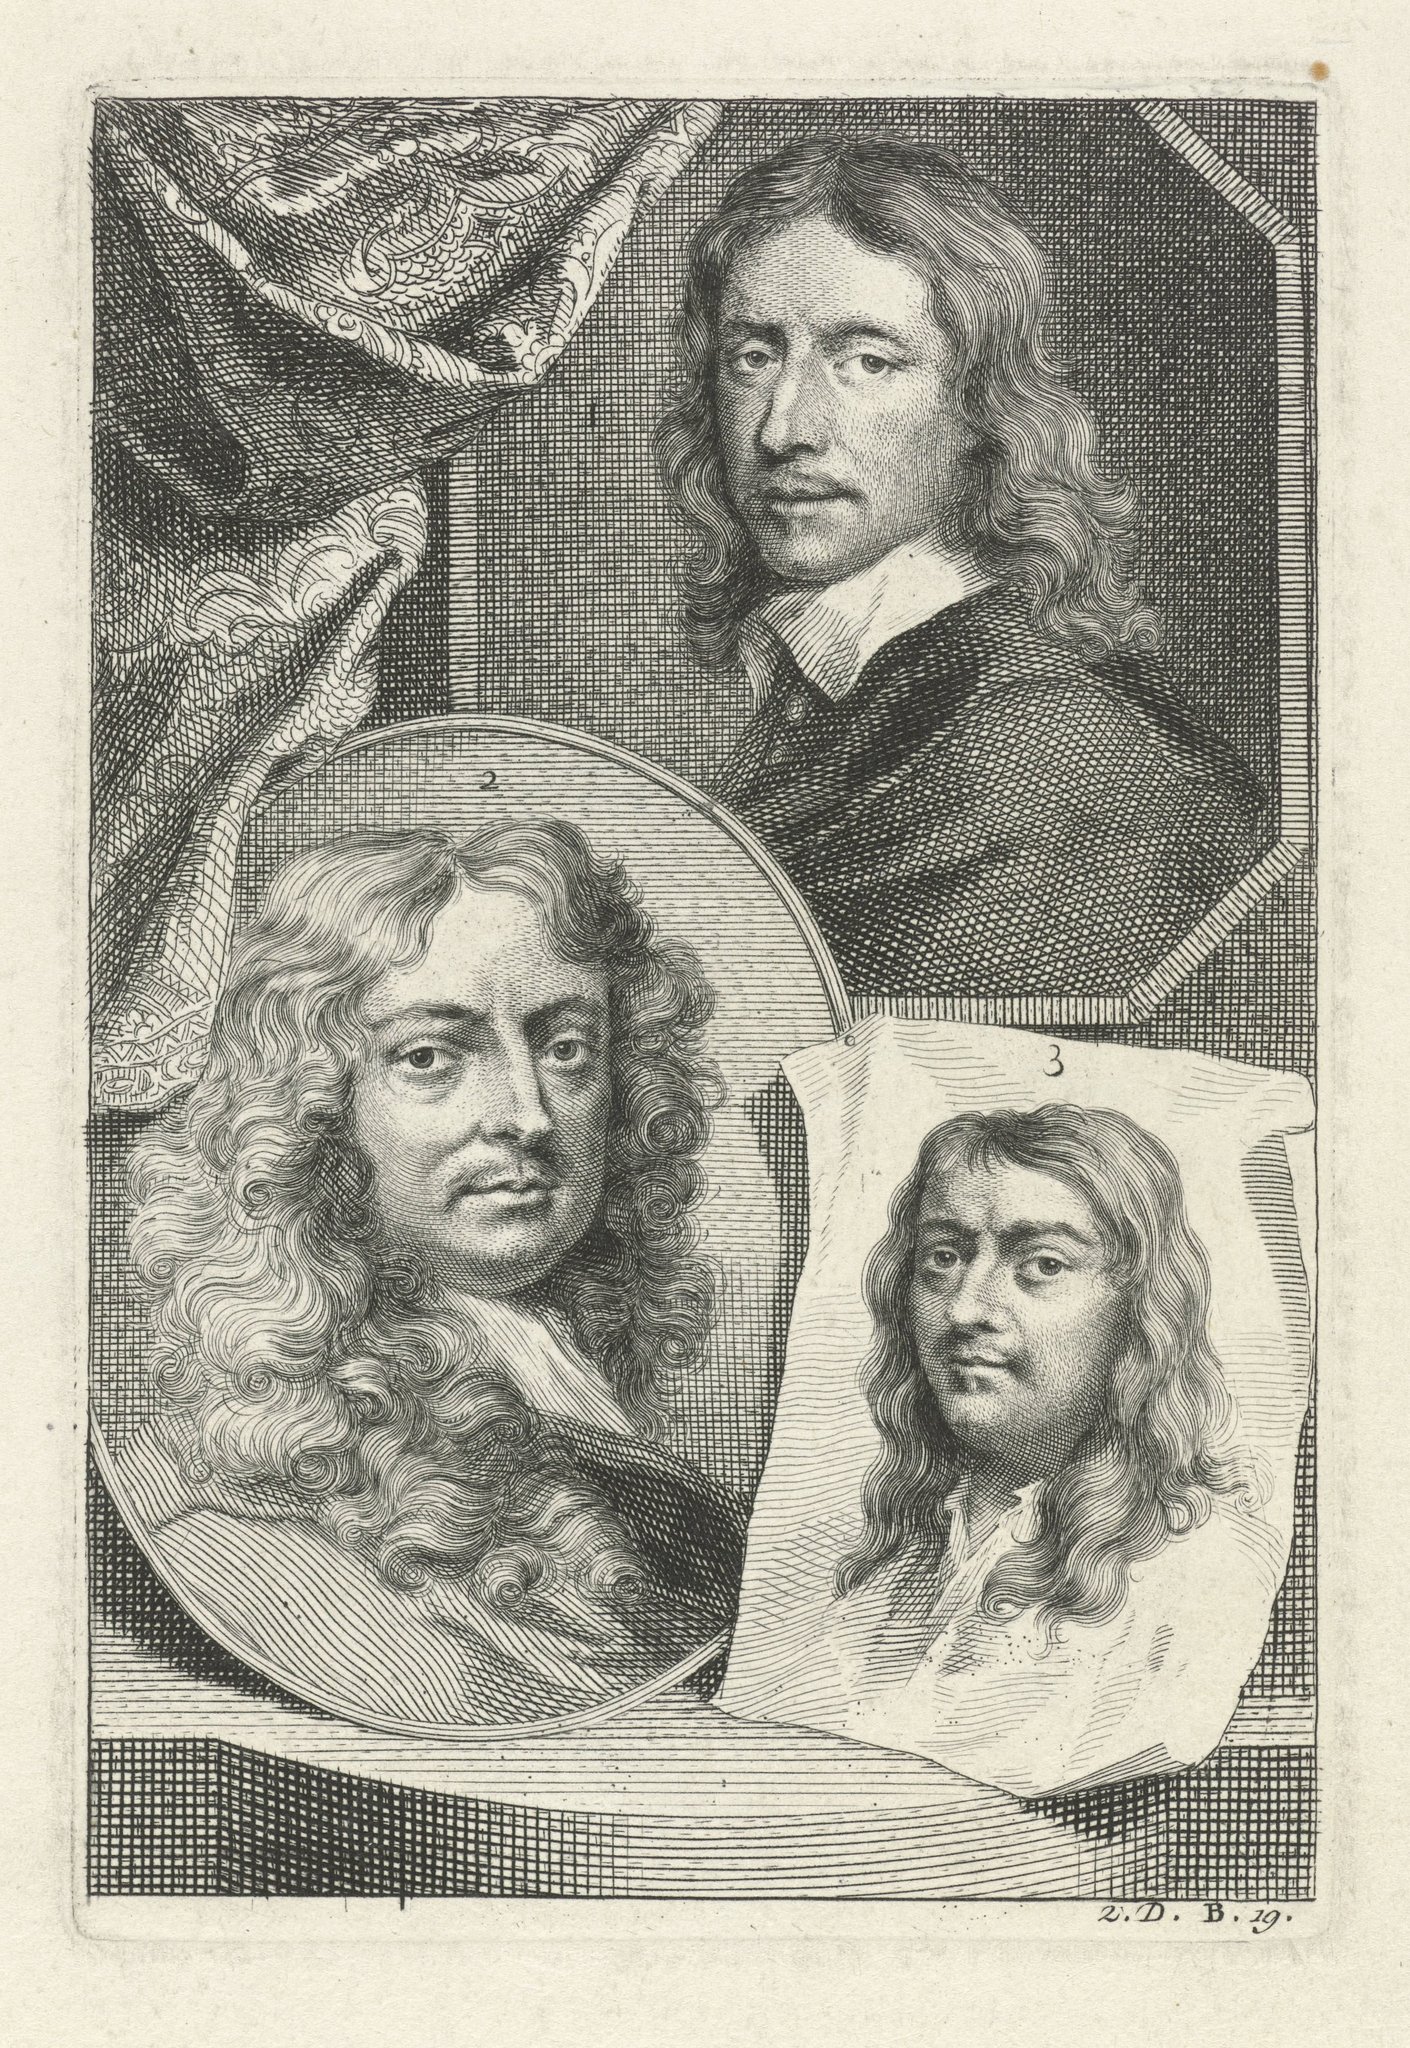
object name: book illustration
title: Portretten van Govert Flinck, Peter Lely en Philips Koninck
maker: jacob houbraken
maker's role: draughtsman, print maker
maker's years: 1698-1780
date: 1753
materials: paper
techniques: engraving, etching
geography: amsterdam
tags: london, peter lely (sir), cleves, govert flinck, amsterdam, painter, draughtsman, philips koninck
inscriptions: collector's mark: Lugt 2228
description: Prent ook gebruikt in: Arnold Houbraken. De groote Schouburgh der Nederlantsche konstschilders en schilderessen : waar van 'er vele met hunne beeltenissen ten tooneel verschynen, ... zynde een vervolg op het Schilderboek van K. van Mander. 3 dln. Tweede druk. Den Haag: 1753.